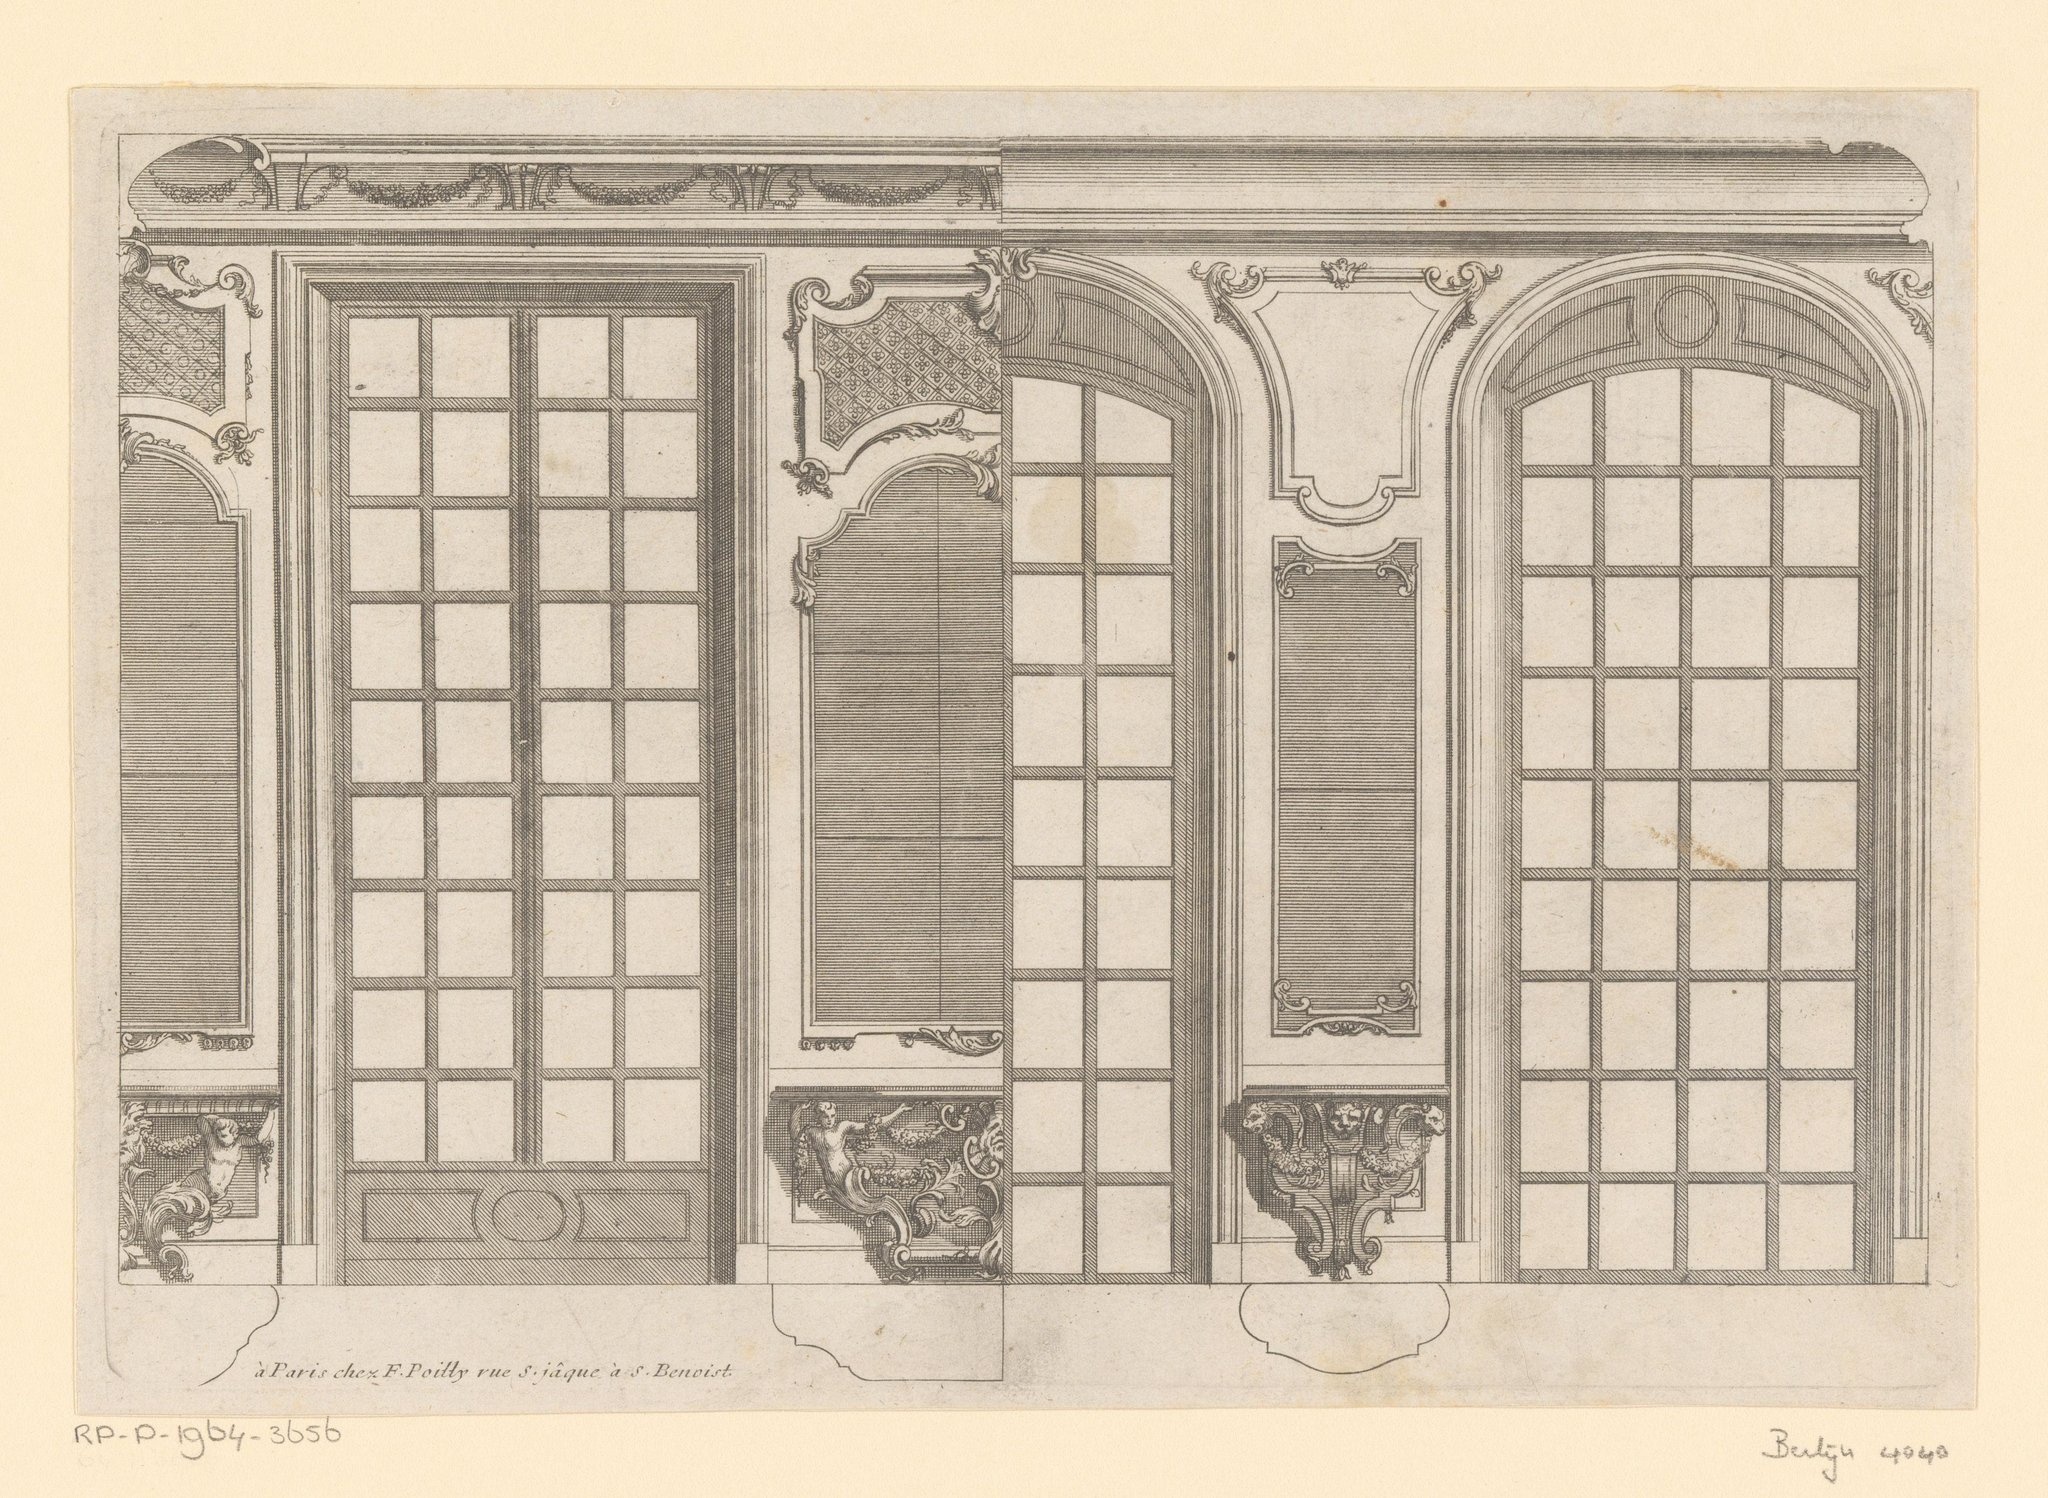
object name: print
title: Nouveaux Lambris, Cheminées Et Portes De Chambre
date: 1681-1723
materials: paper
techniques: engraving, etching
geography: paris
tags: window, panelling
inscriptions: collector's mark: Lugt 2760, collector's mark: Lugt 2228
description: Links een raam geflankeerd door panelen, rechts een paneel geflankeerd door ramen. Voor de panelen staan geornamenteerde tafels met halffiguren en dieren.